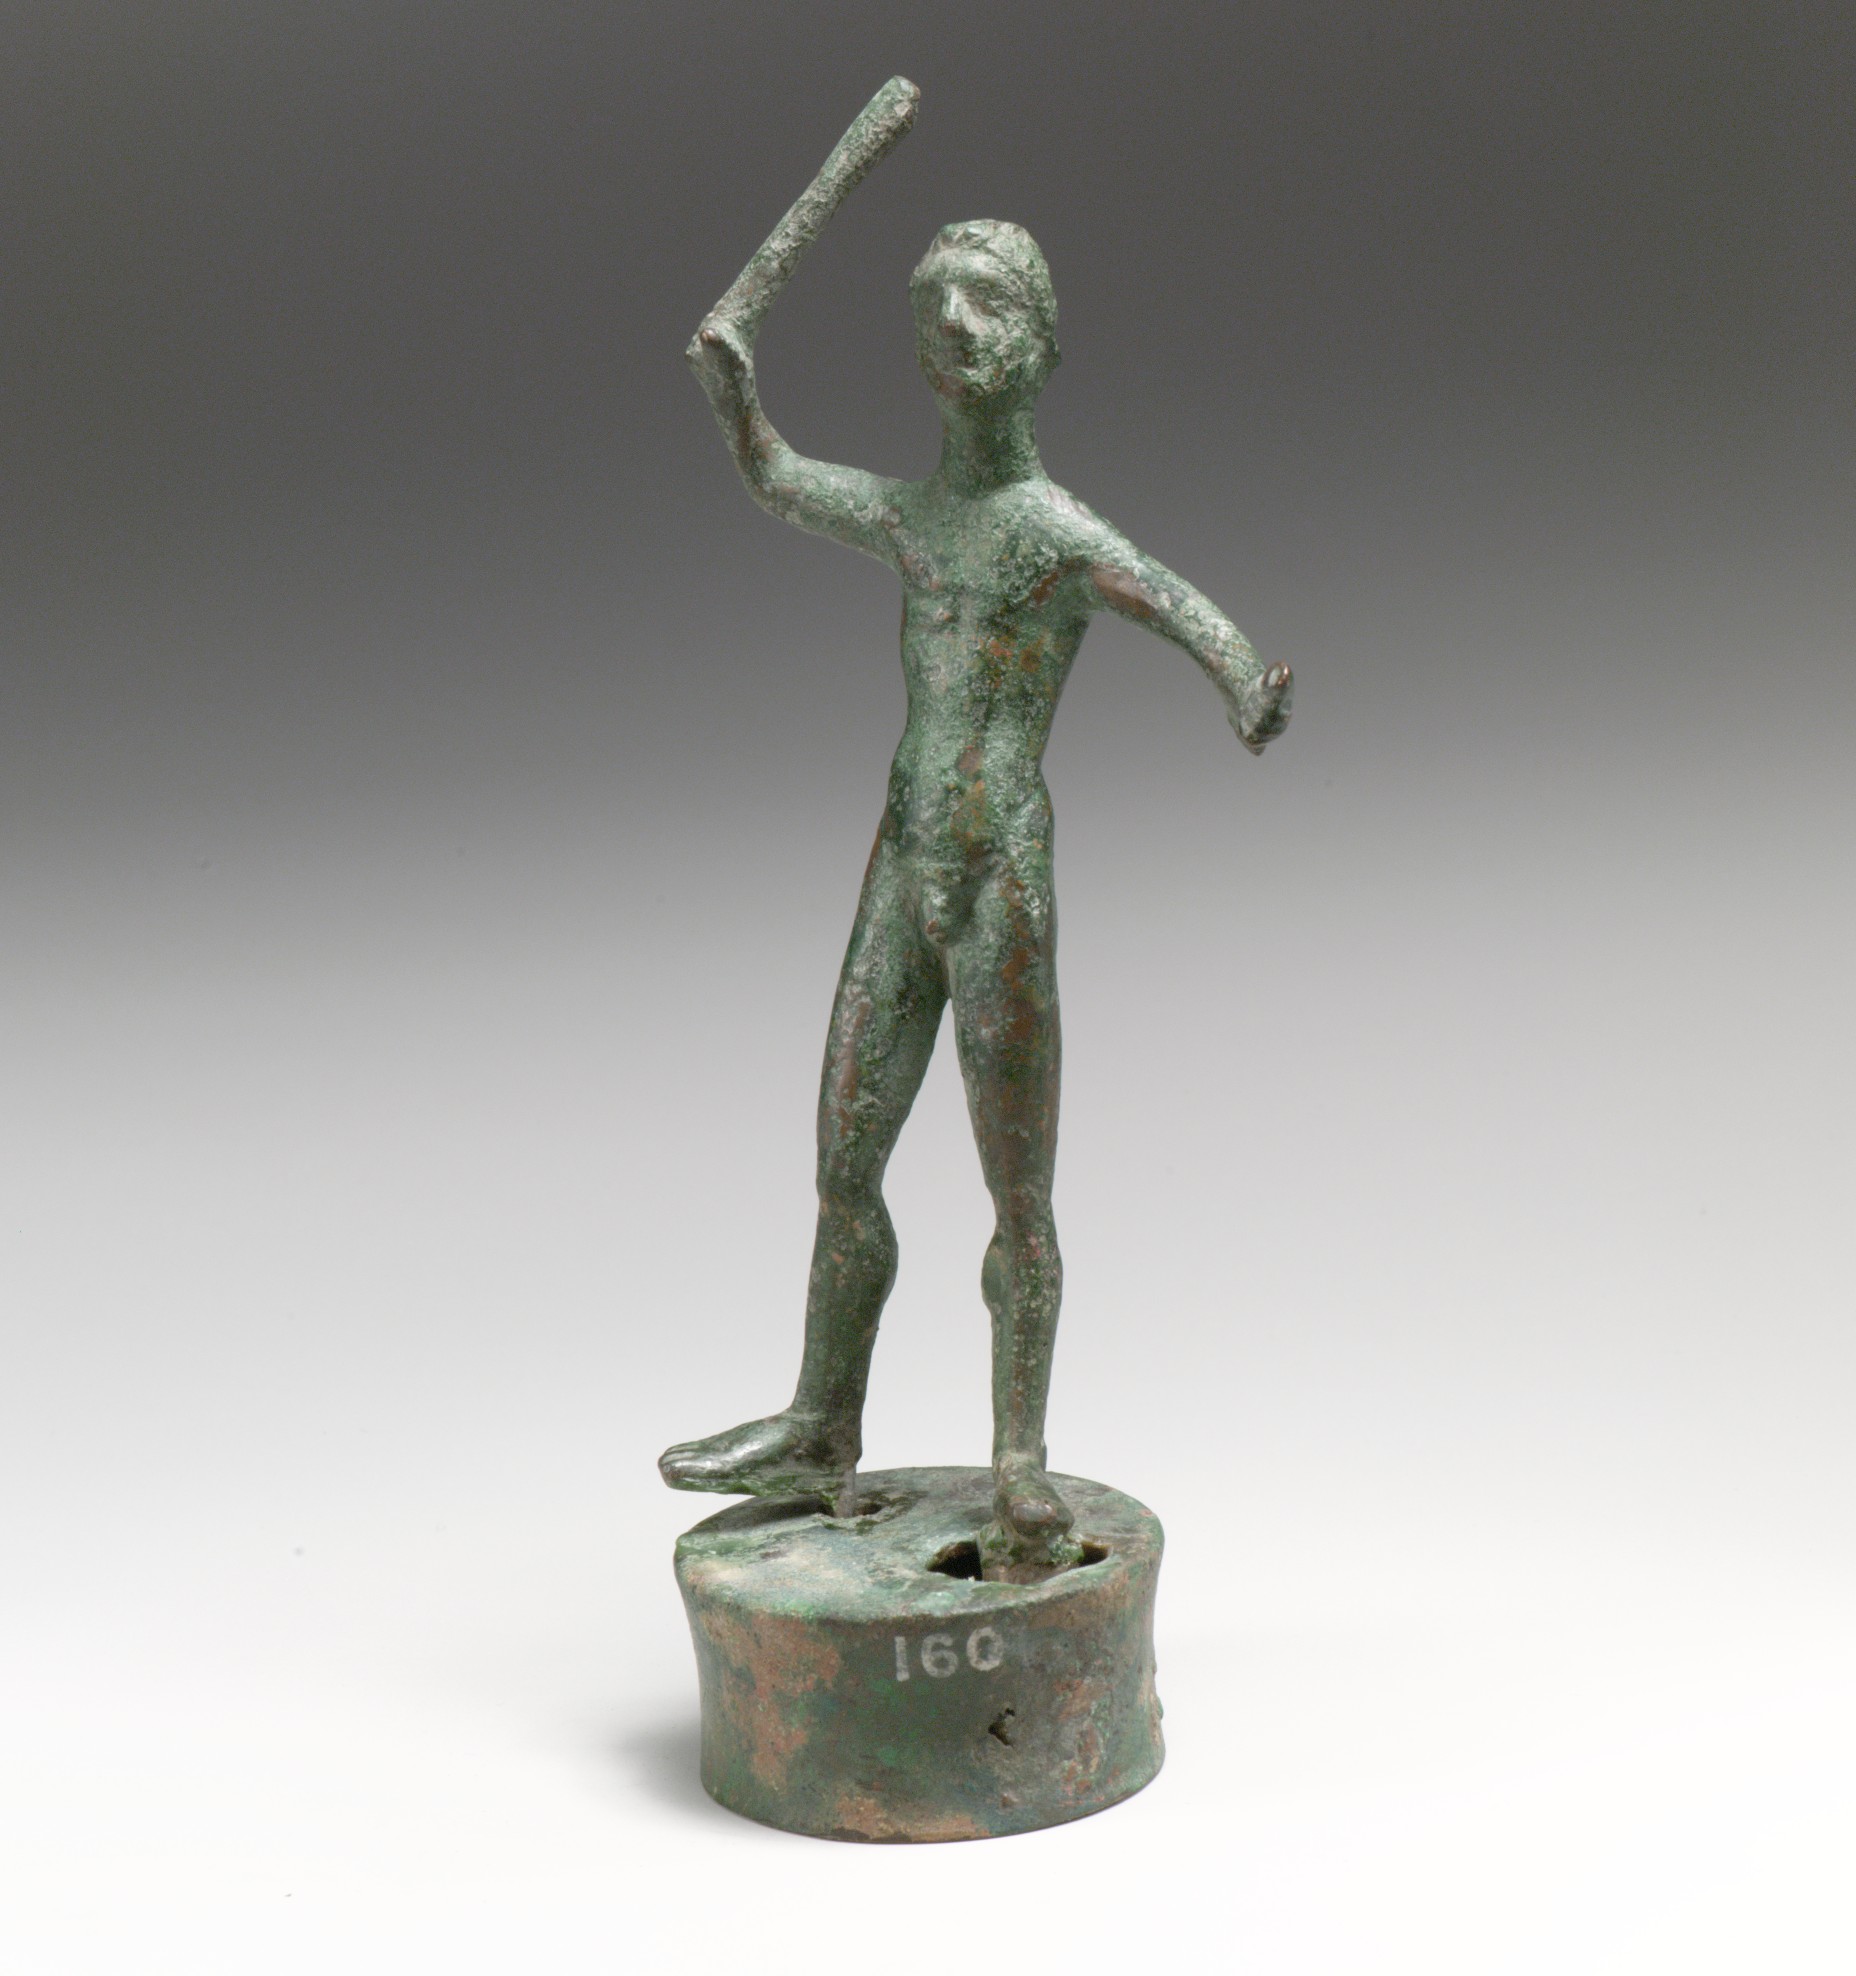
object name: statuette of herakles with fillet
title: Bronze statuette of Herakles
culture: italic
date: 300-1 BCE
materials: bronze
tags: herakles